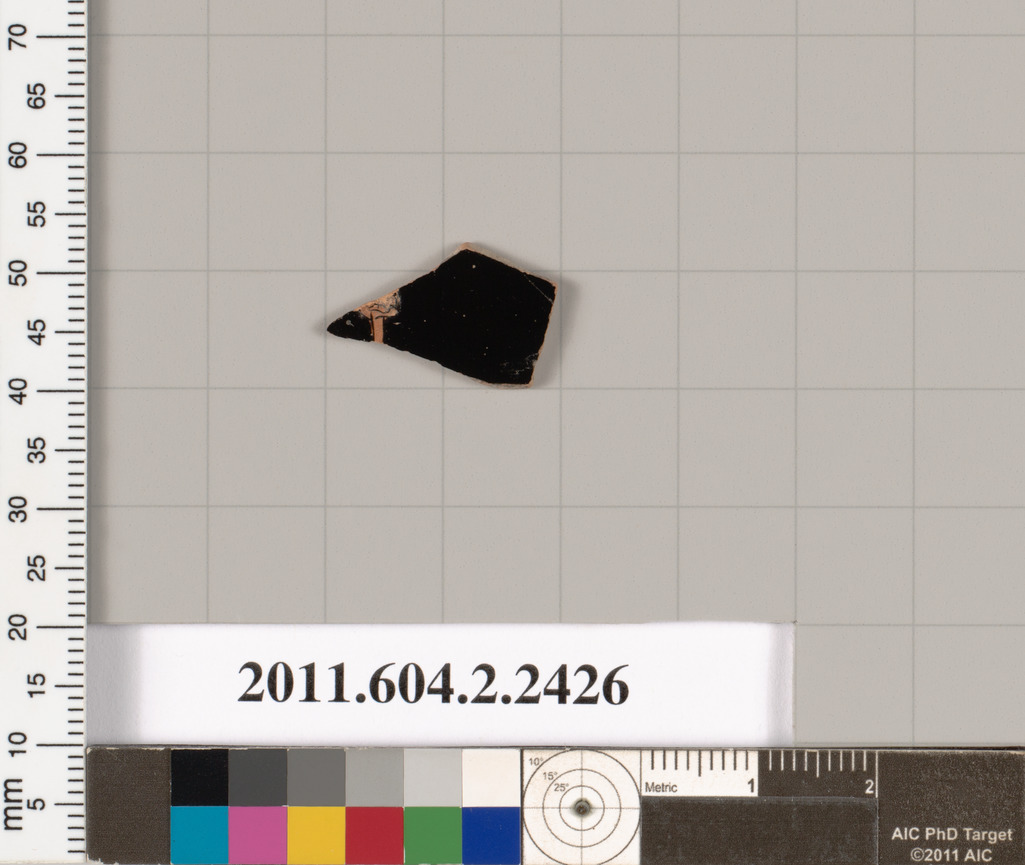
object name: undetermined shape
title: Terracotta fragment of an undetermined shape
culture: greek, attic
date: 480-460 BCE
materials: terracotta